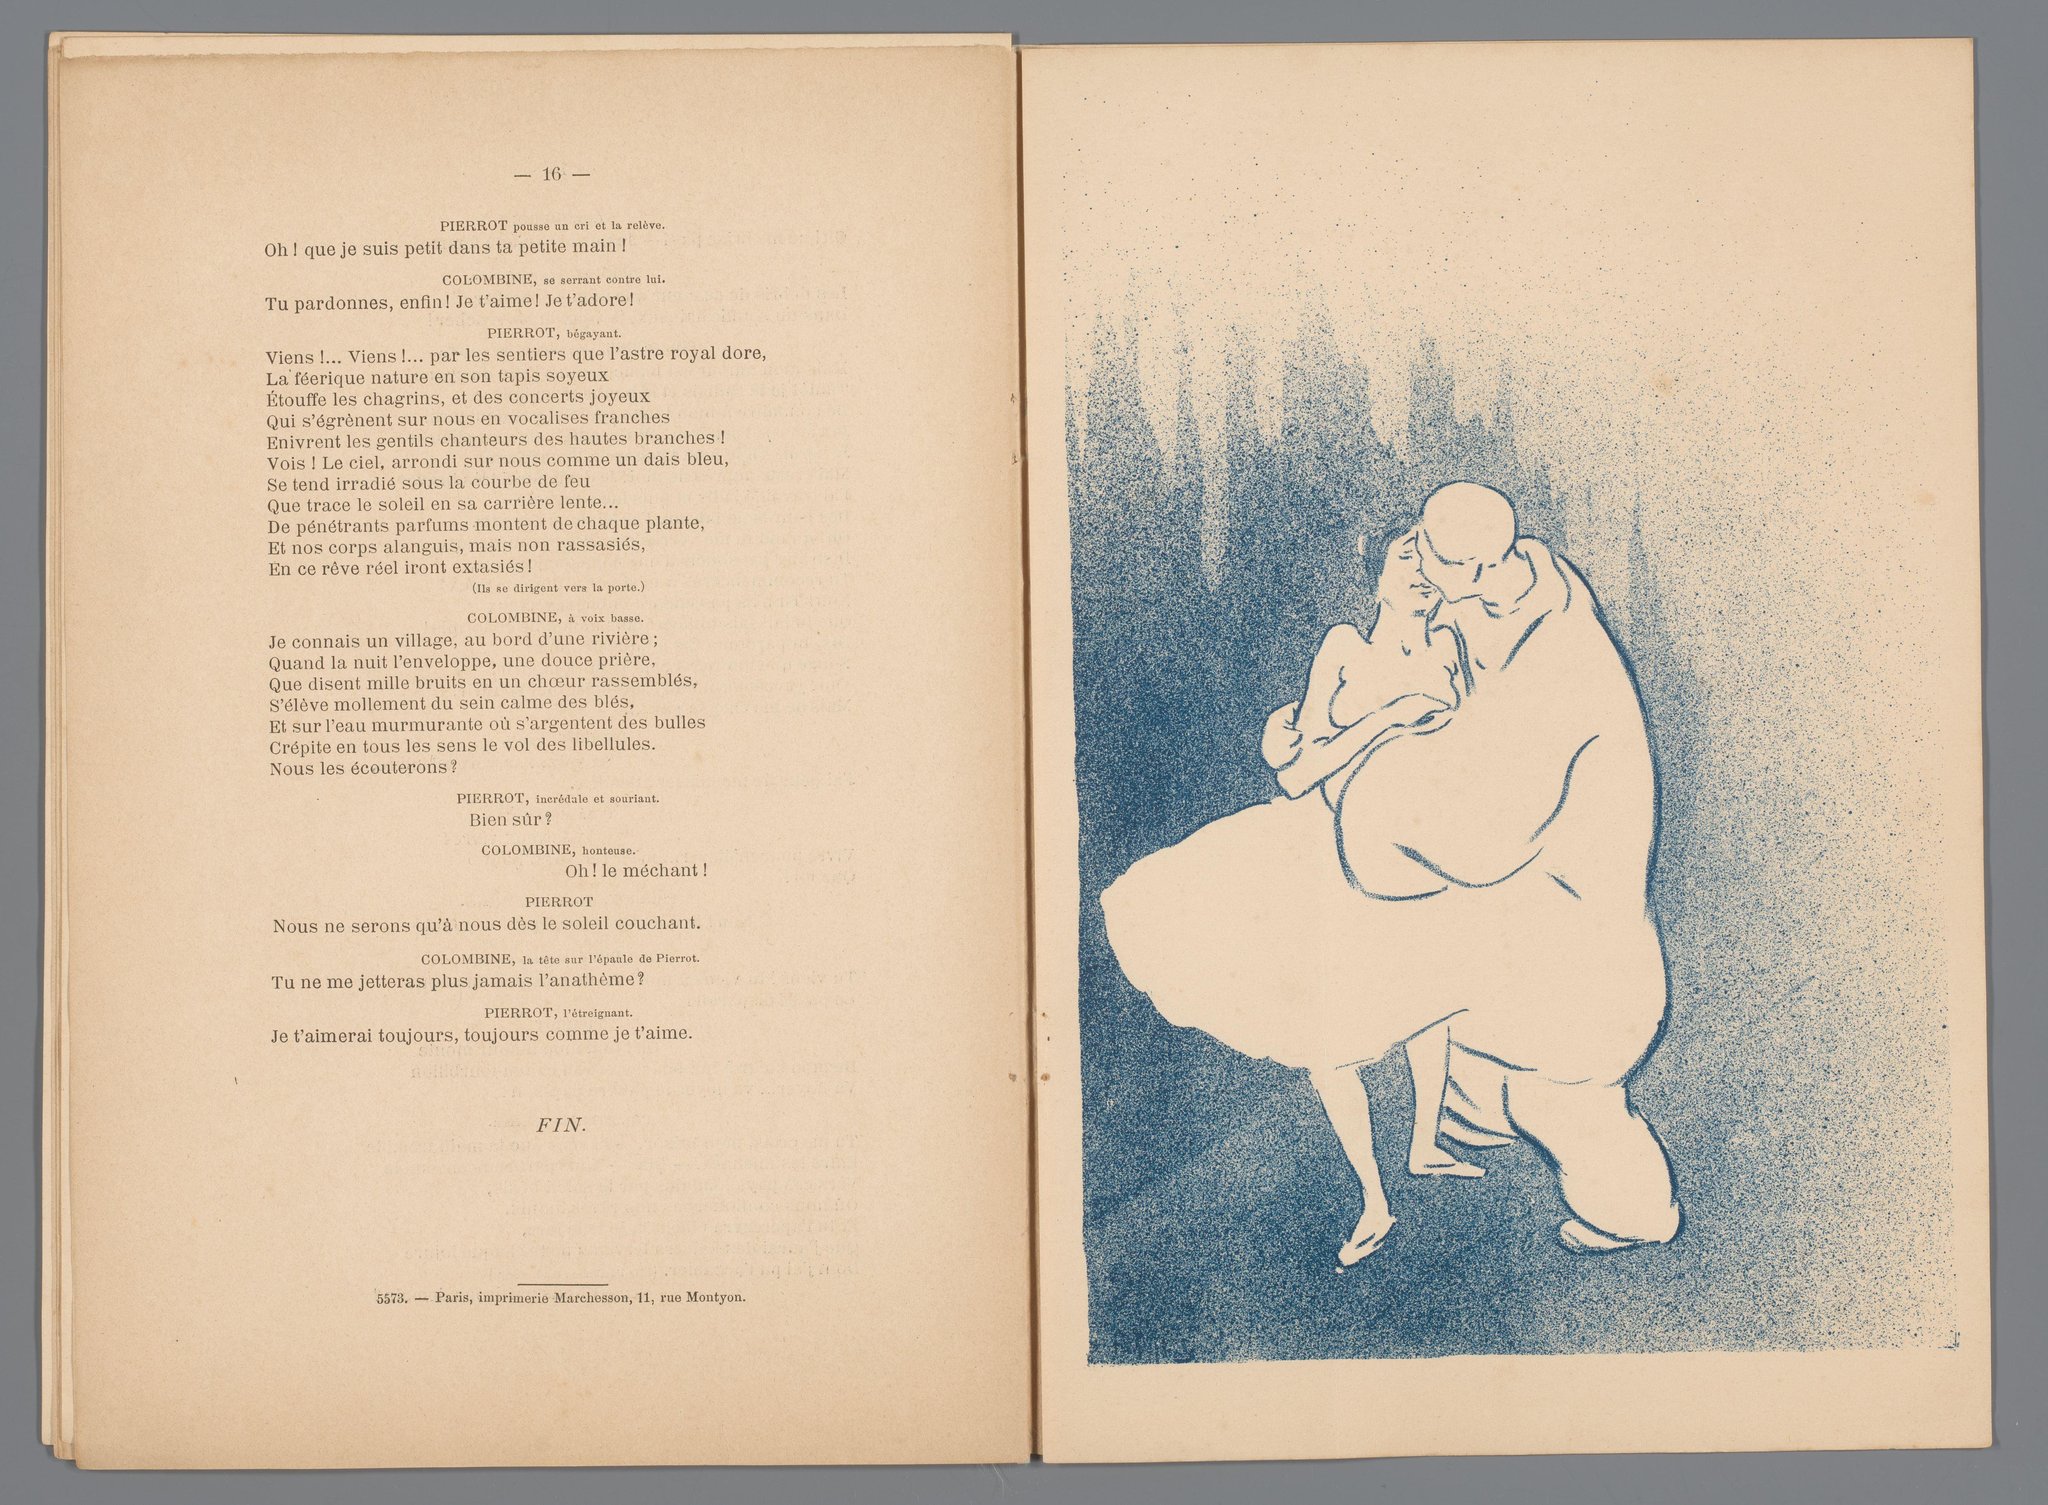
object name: print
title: L'amour s'amuse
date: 1892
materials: paper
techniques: lithograph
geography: paris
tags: (lovers) embracing each other, 'symplegma', (lovers) kissing each other, female dancer